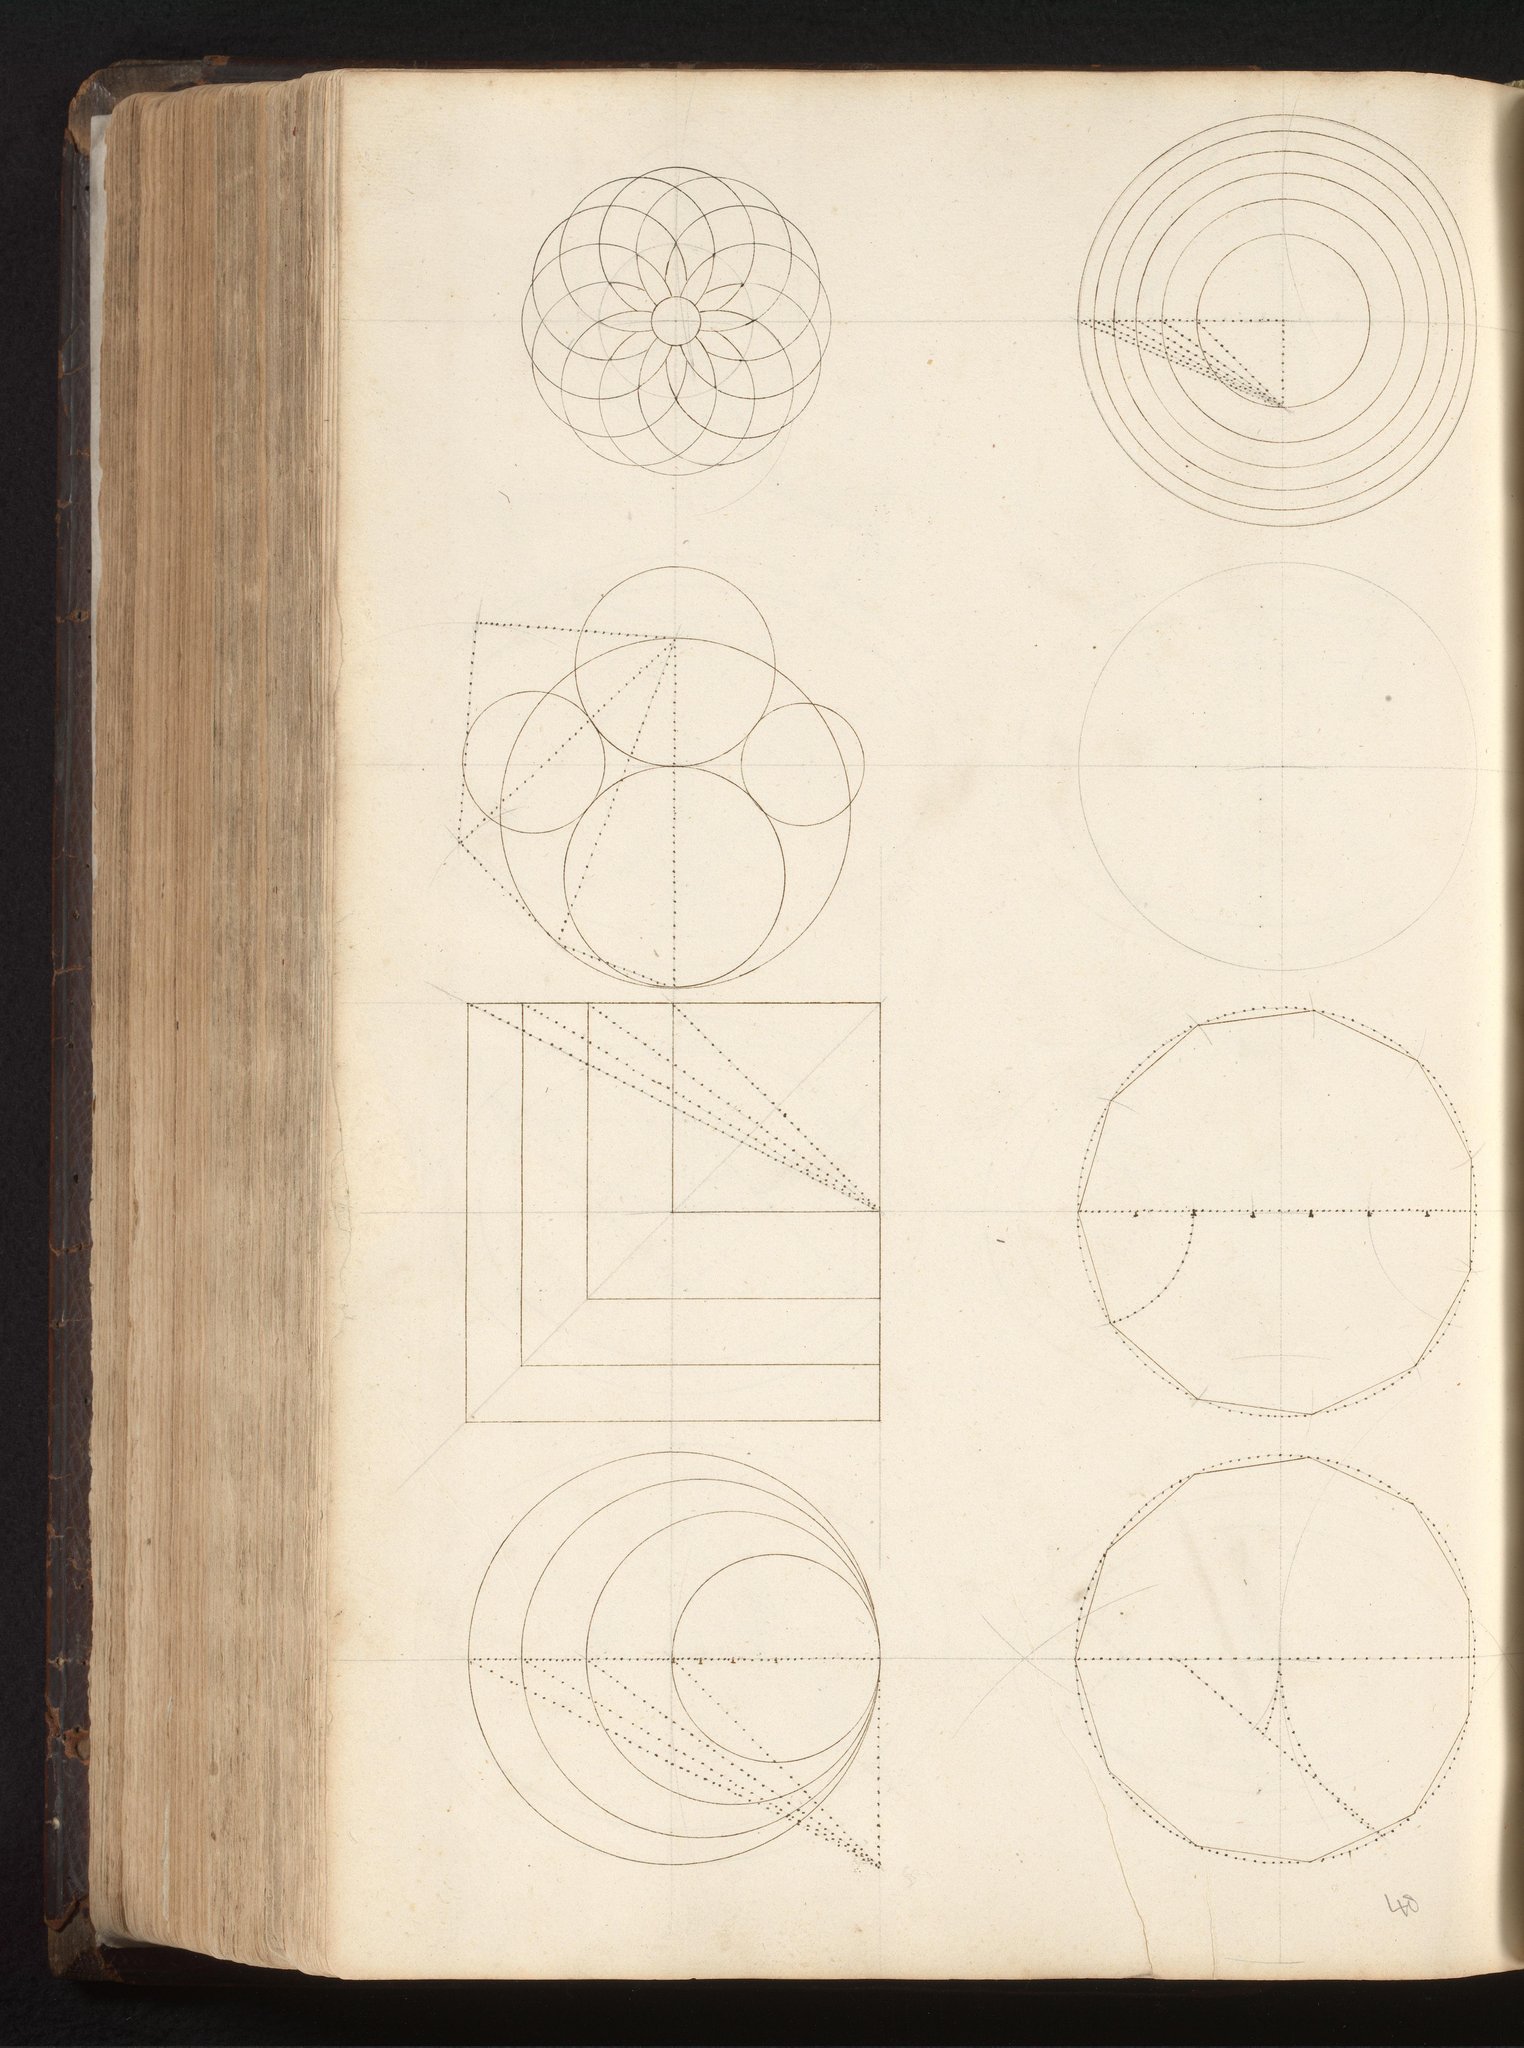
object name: album leaf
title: Geometrische figuren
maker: Anonymous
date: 1650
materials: ink, paper, pencil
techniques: pen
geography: low countries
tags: planimetry, geometry